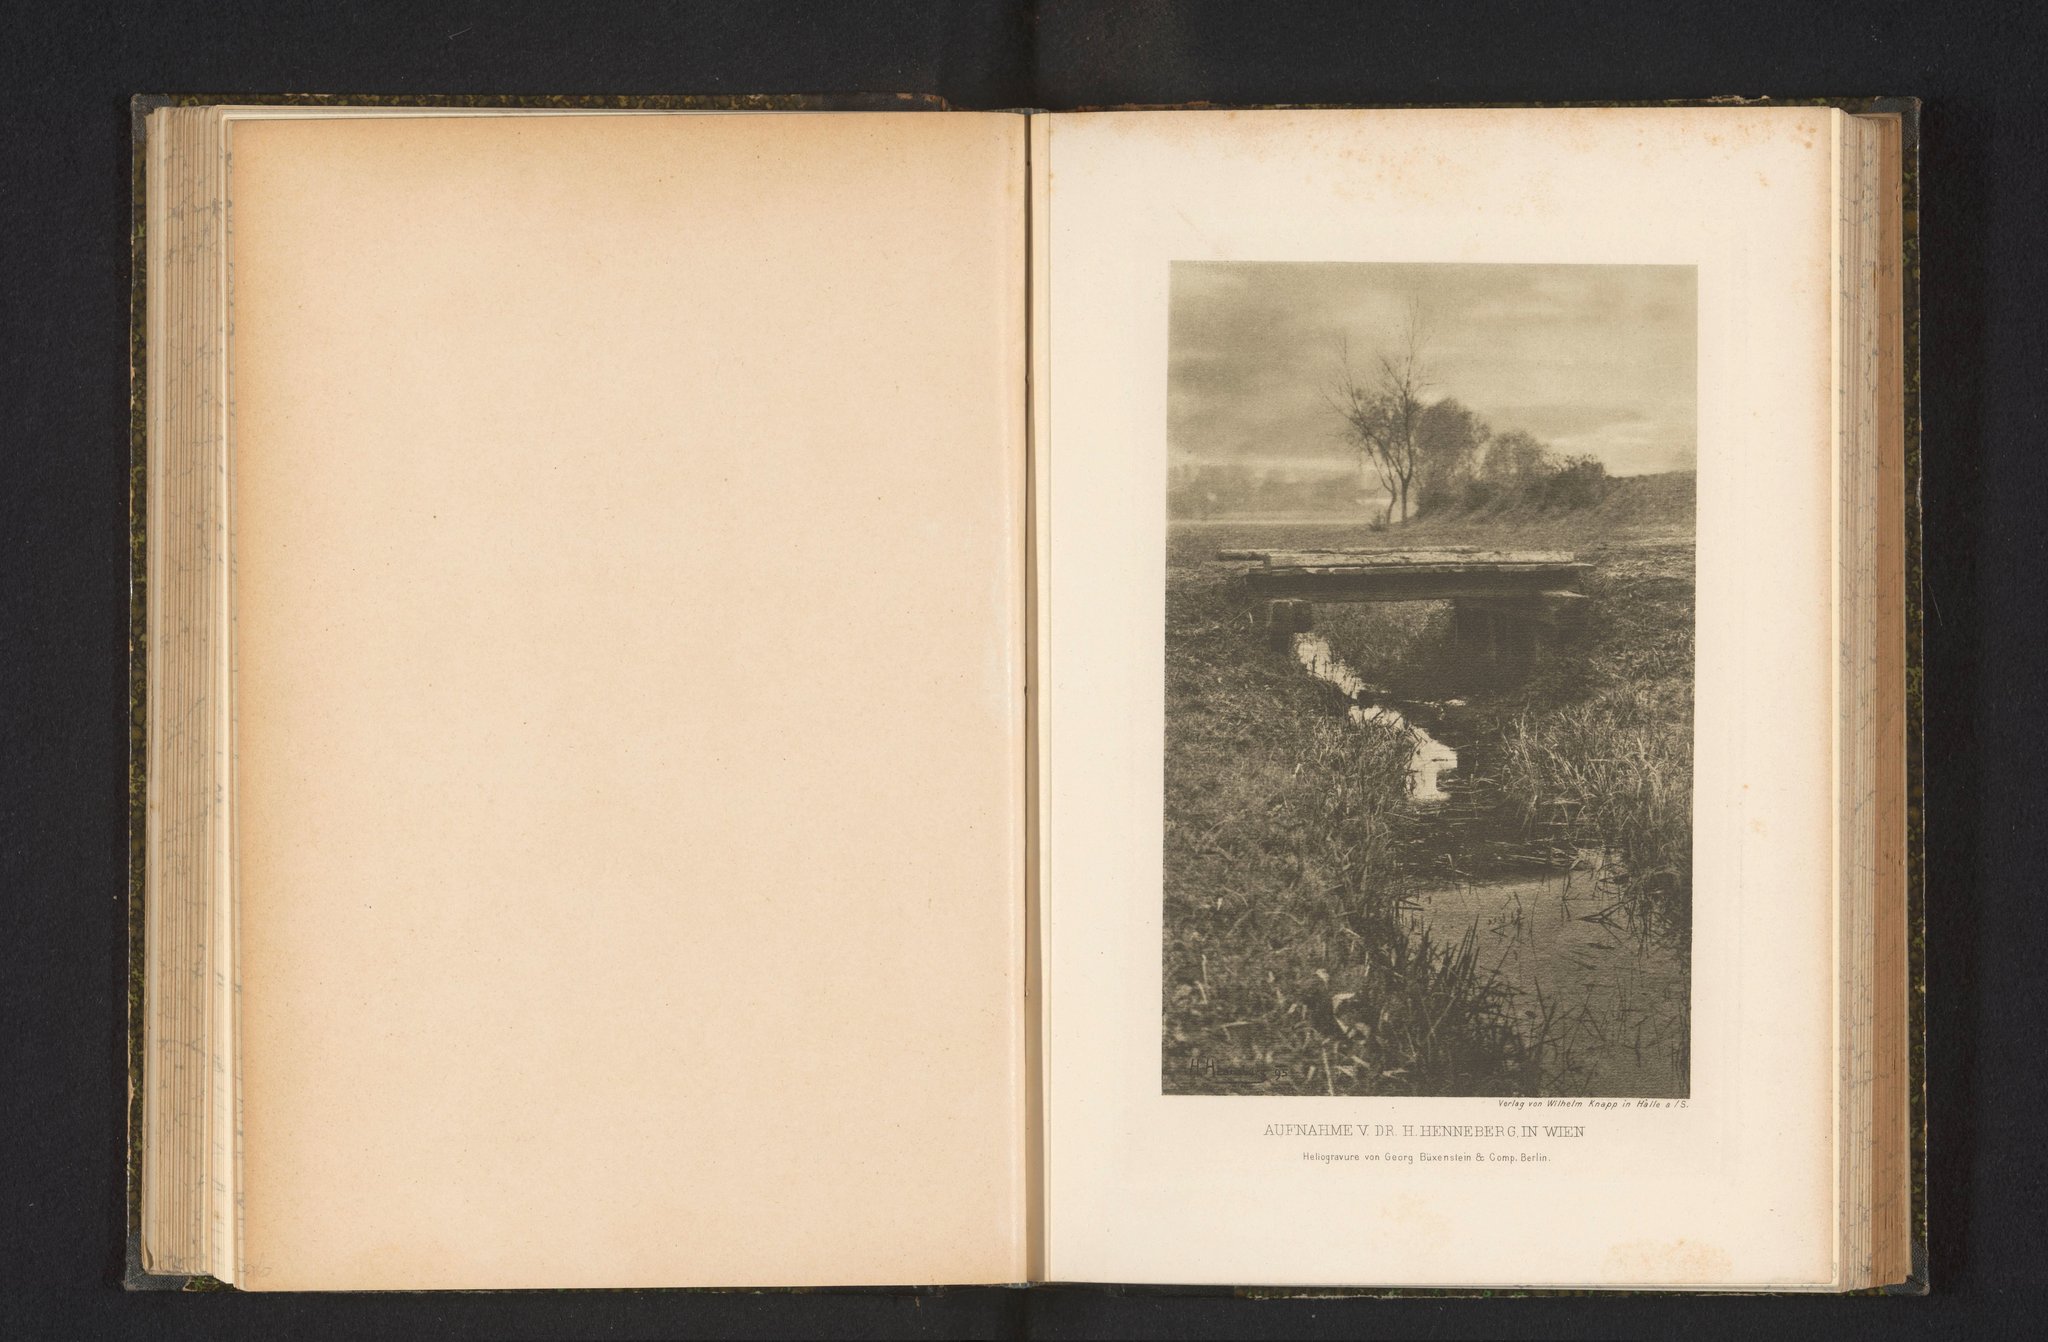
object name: photomechanical print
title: Brug over een sloot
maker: hugo henneberg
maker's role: fotograaf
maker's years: 1863-1918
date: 1893-1898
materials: paper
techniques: photoaquatint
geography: vienna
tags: brook, bridge